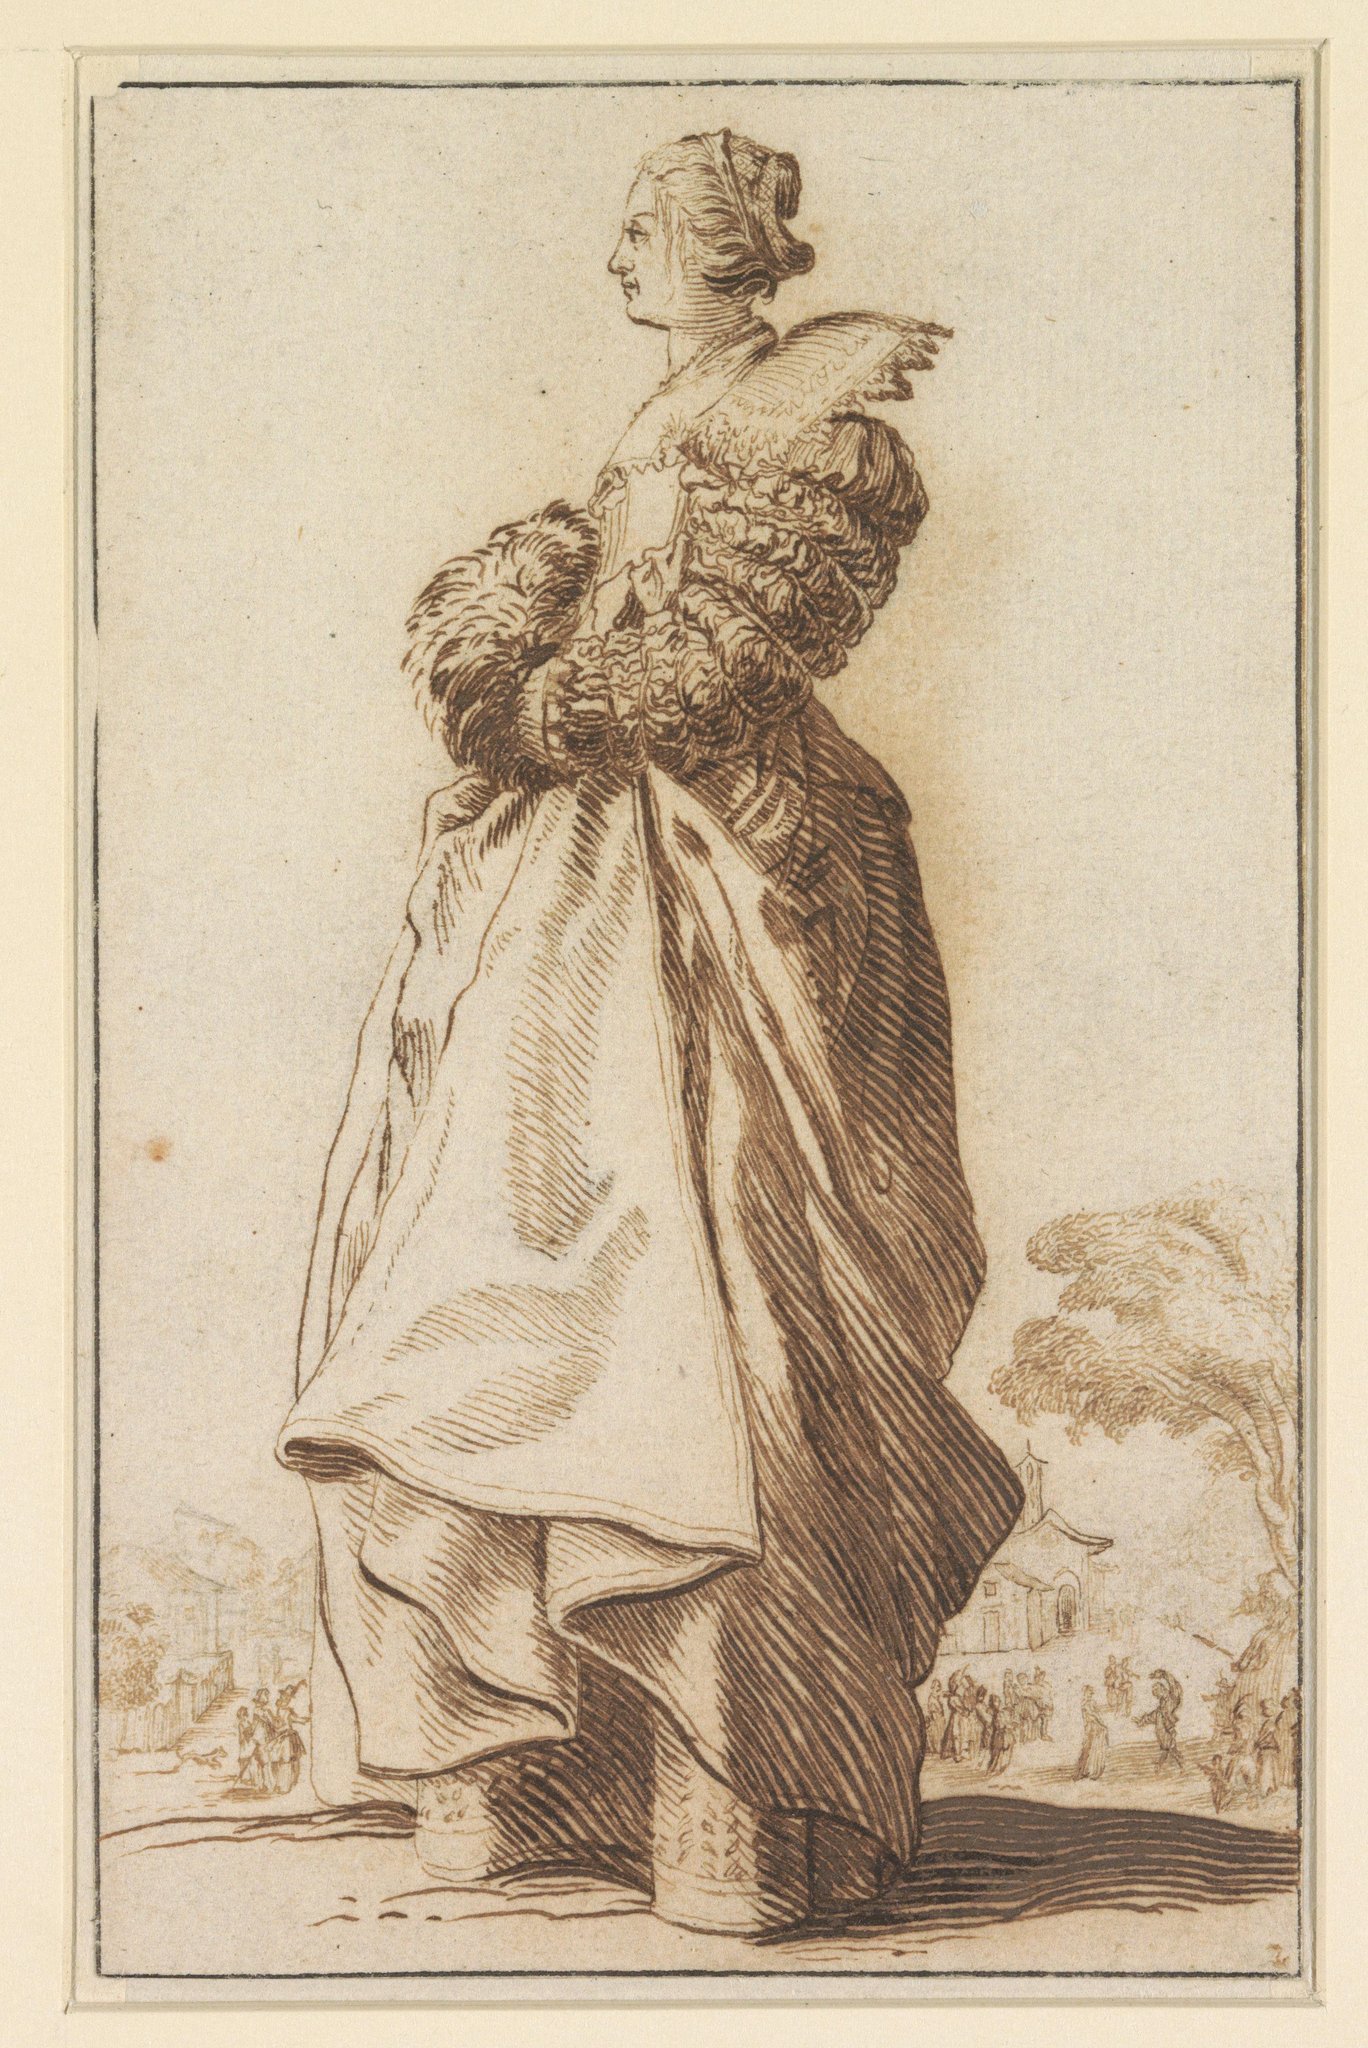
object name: drawing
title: Staande dame, naar links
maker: antoon overlaet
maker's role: draughtsman, print maker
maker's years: 1720-1774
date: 1730-1774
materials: ink, paper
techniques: pen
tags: standing figure - aa - female human figure